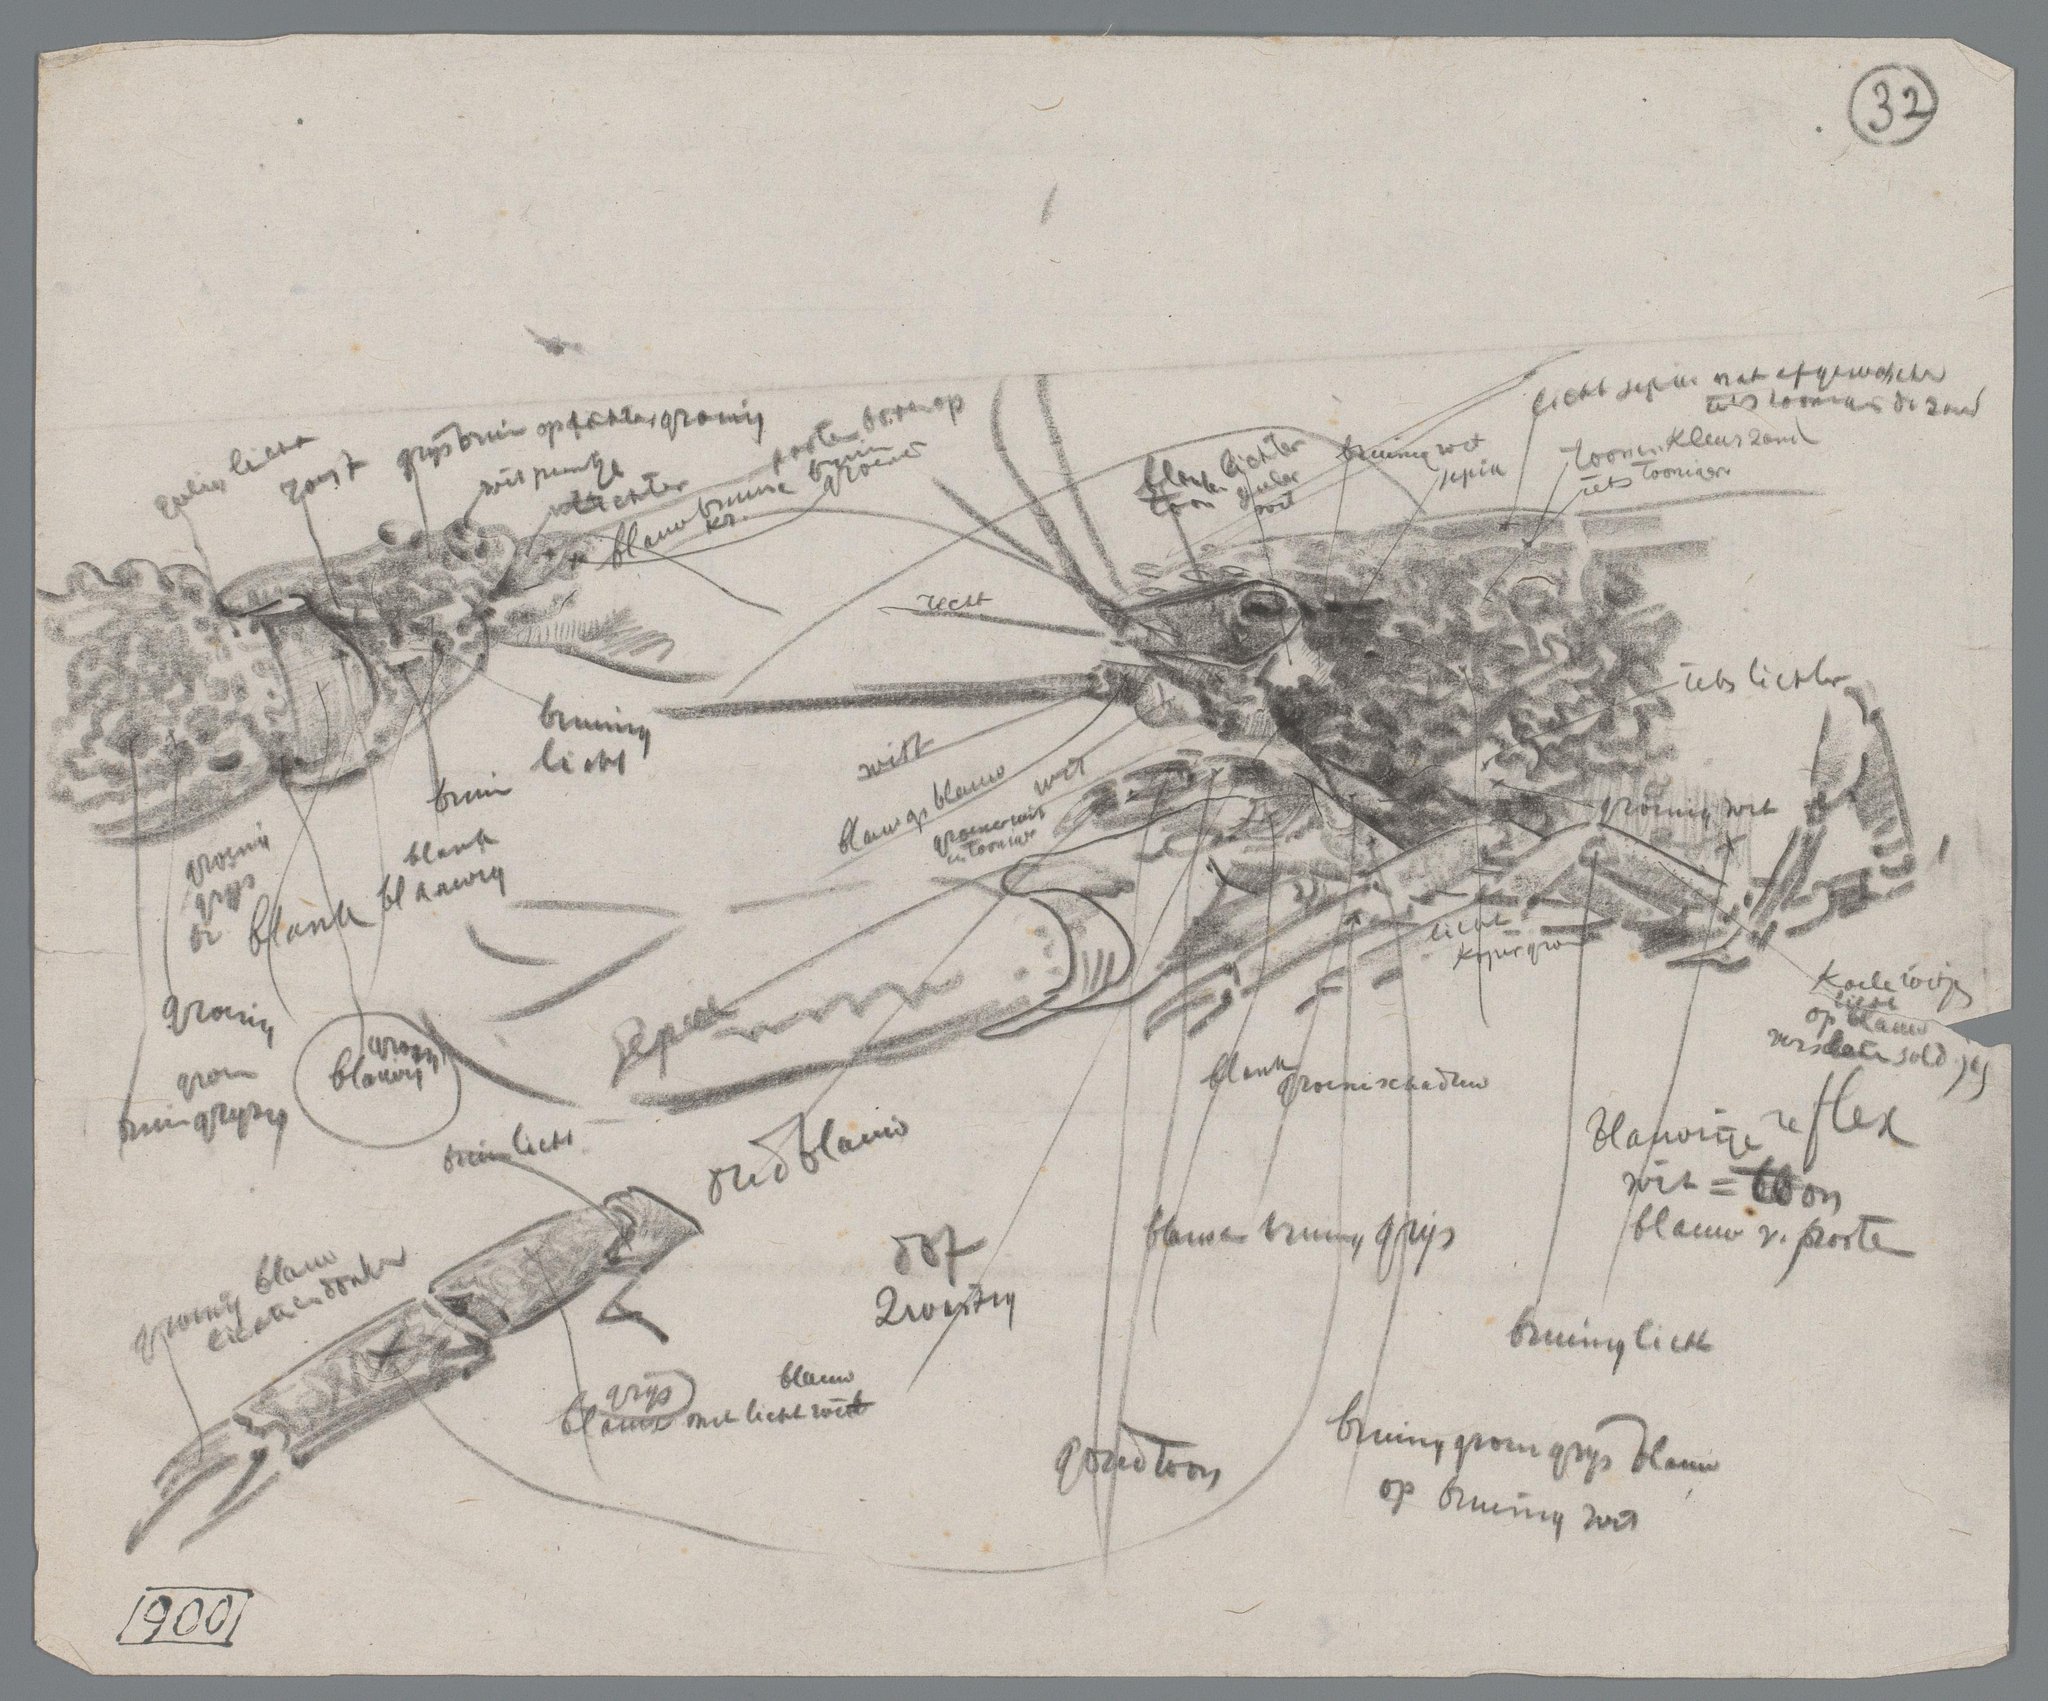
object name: drawing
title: Studies van lichaamsdelen van een kreeft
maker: gerrit willem dijsselhof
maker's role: designer, draughtsman, print maker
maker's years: 1866-1924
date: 1876-1924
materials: chalk, paper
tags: crustaceans: lobster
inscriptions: number: ‘32’, number: ‘900’